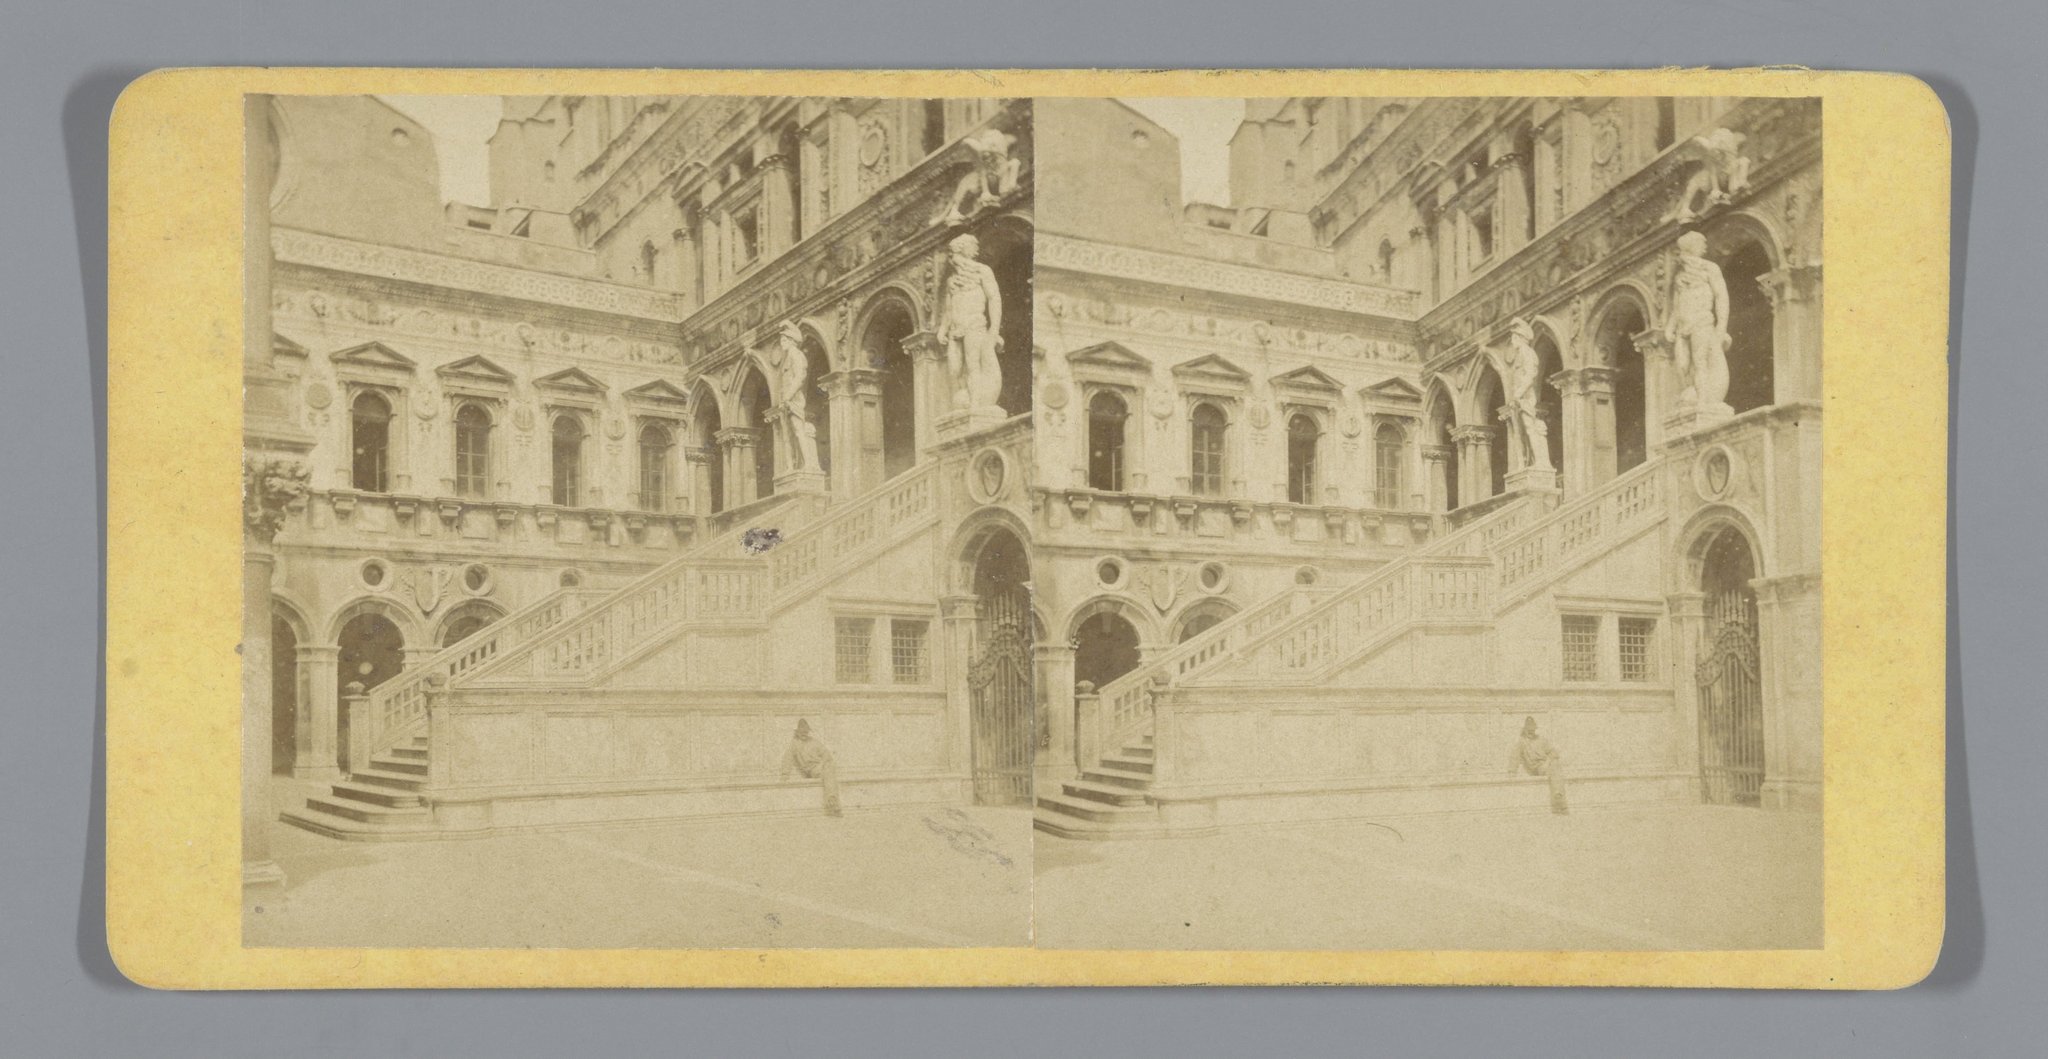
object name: stereograph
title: Scala dei Giganti op de binnenplaats van het Dogenpaleis te Venetië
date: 1860-1880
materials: cardboard, photographic support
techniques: albumen print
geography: venice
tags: staircase, inner court of palace or 'hôtel'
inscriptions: inscription: ‘Scala dei Giganti di fianci’, number: ‘26’, name: ‘C. Coen e Figlio Venezia Trieste’